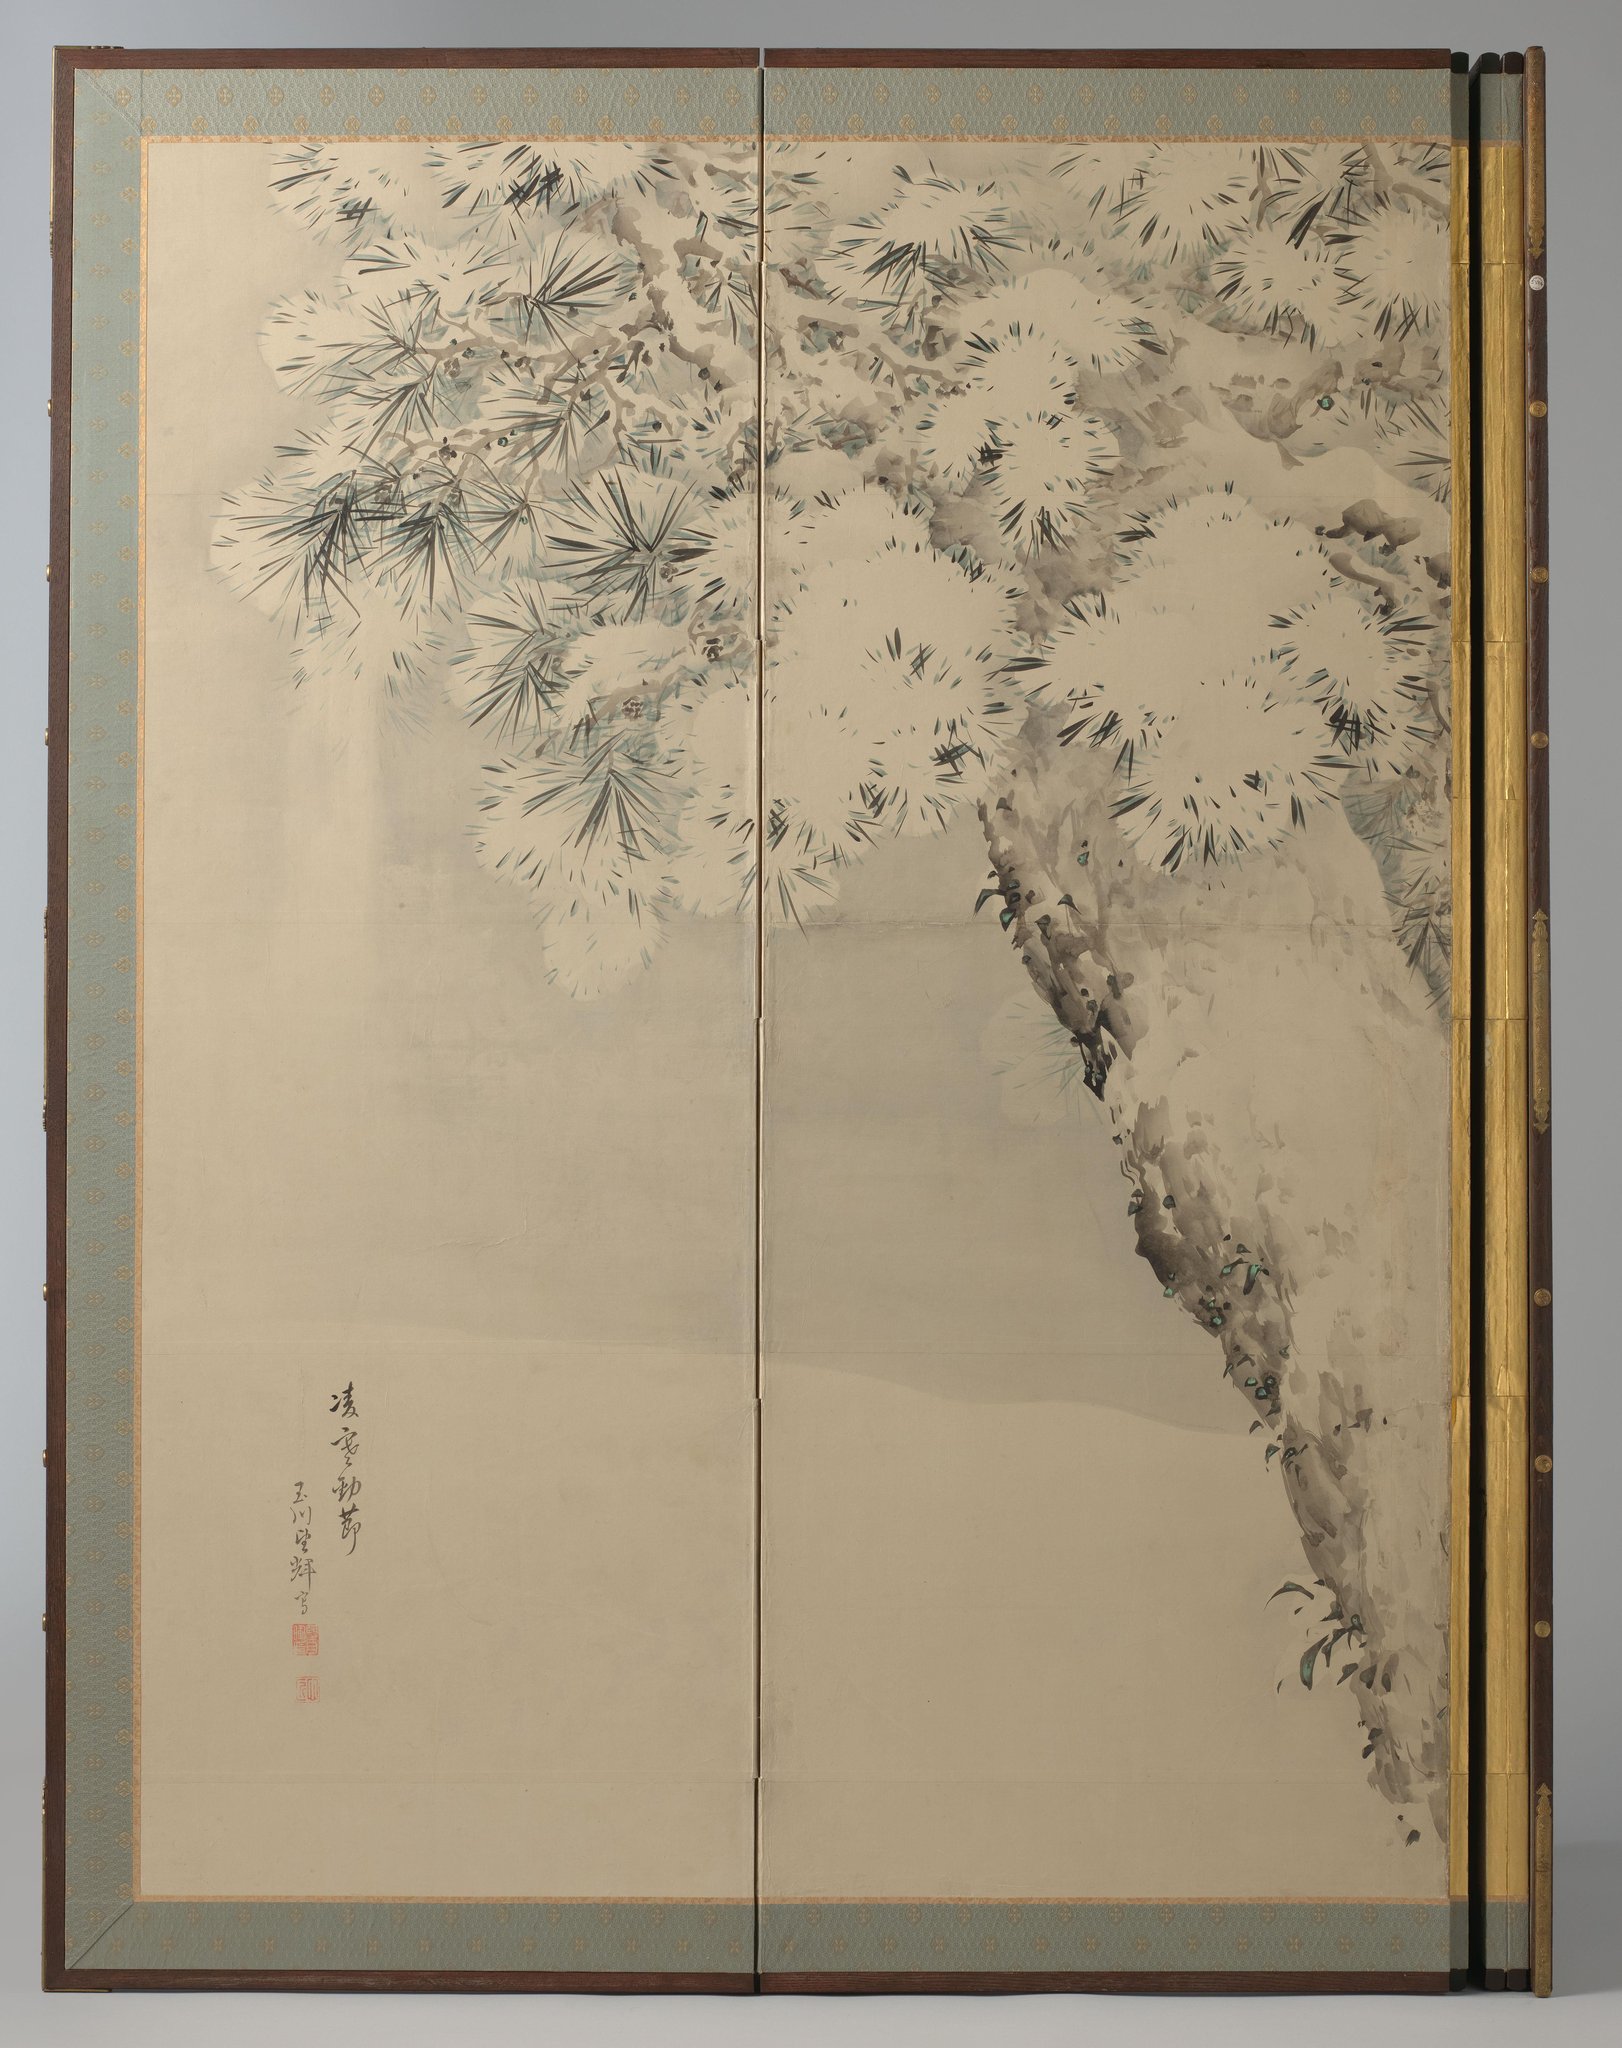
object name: vouwscherm, kamerscherm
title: Three Friends of Winter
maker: mochizuki gyokusen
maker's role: painter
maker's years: 1794-1852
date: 1800-1850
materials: ink, paper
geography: japan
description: The ‘three friends of winter’ comprise bamboo, pine and plum. The first two remain green in winter, while the plum blossoms herald spring. The pine tree makes it clear that the worst of the cold is over: snow is slipping off a branch. Gyokusen cleverly used the white of the paper to suggest snow.